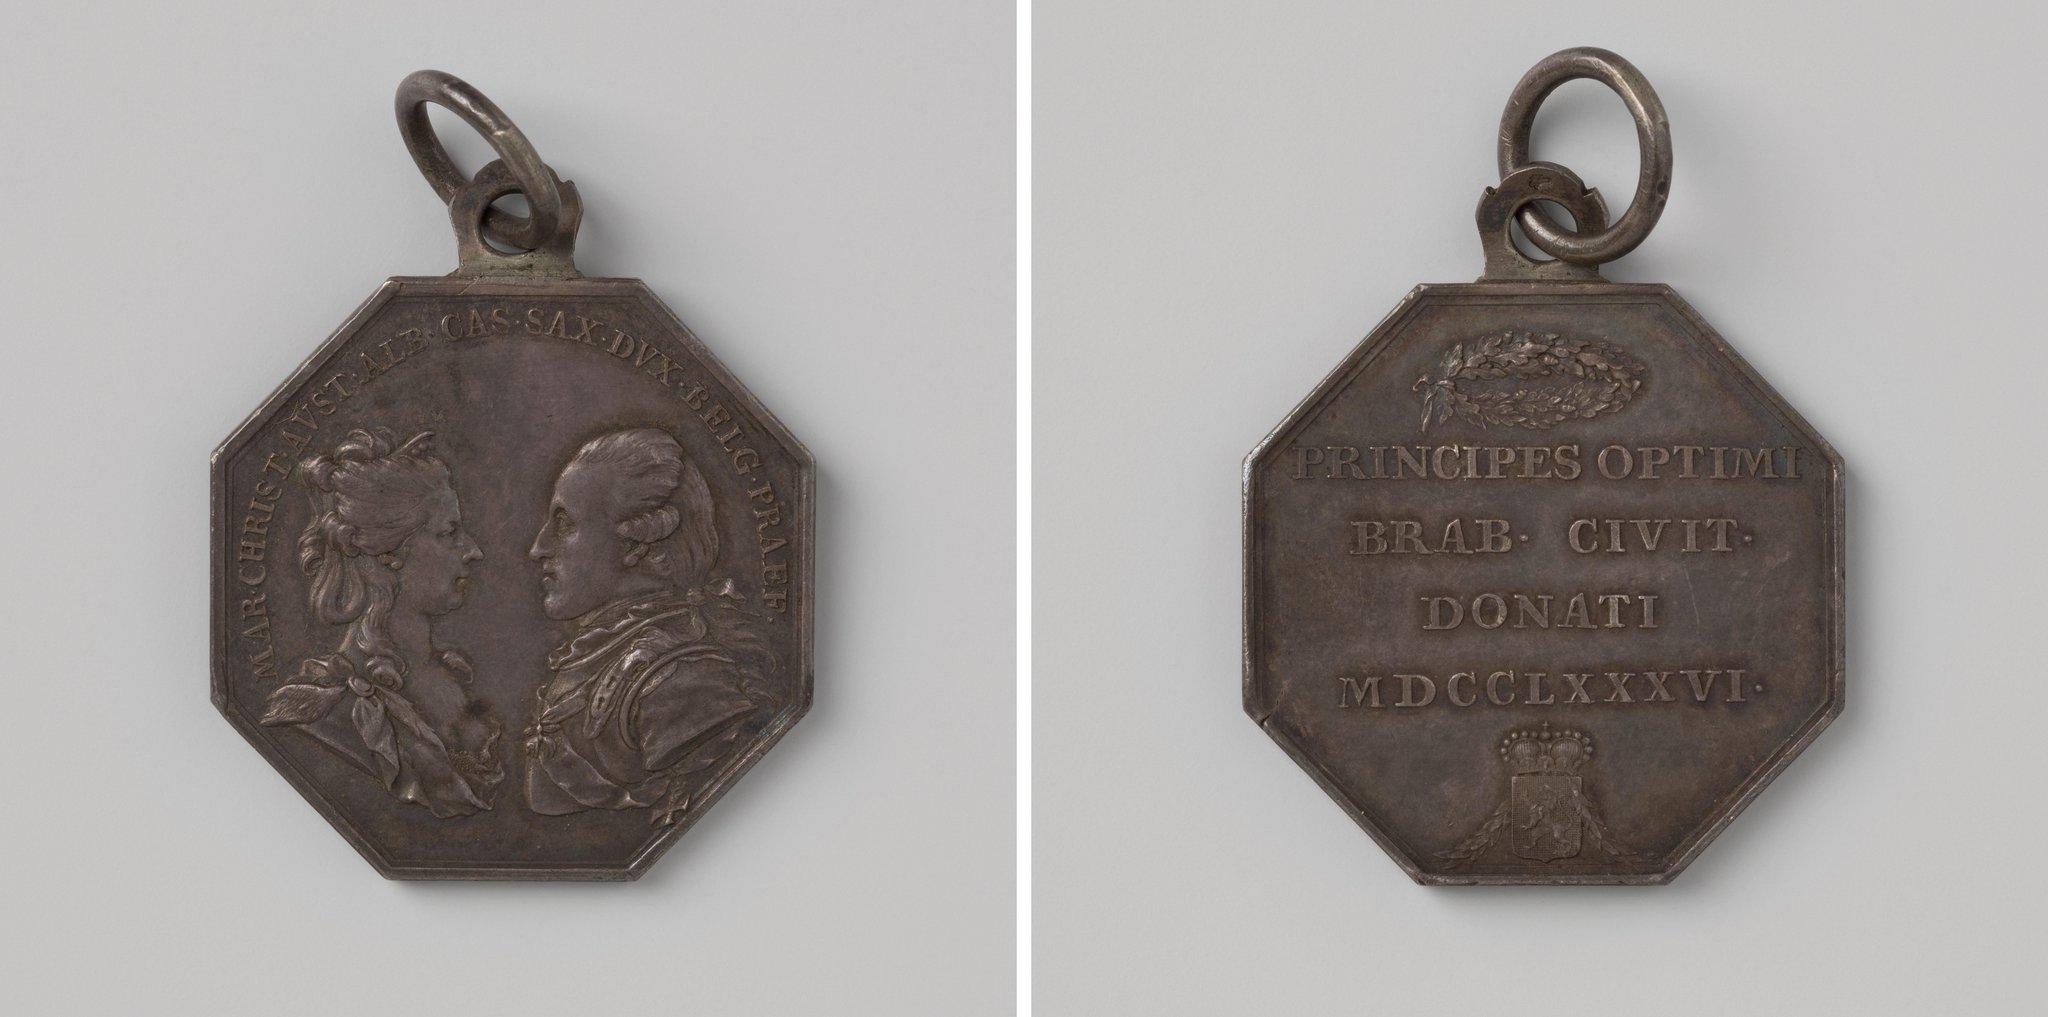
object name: history medal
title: Maria Christina en Albert-Kasimir, landvoogden der zuidelijke Nederlanden, penning vereerd door het gewest Brabant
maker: Anonymous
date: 1786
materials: silver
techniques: striking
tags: albert casimir van saksen-teschen, vienna, maria christina van oostenrijk (1742-1798), brabant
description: Zilveren achthoekige penning met draagoog en draagring. Voorzijde: naar elkaar gewende borststukken van man en vrouw binnen omschrift. Keerzijde: opschrift onder lauwerkrans, boven gekroond wapenschild, omhangen met bladertakken